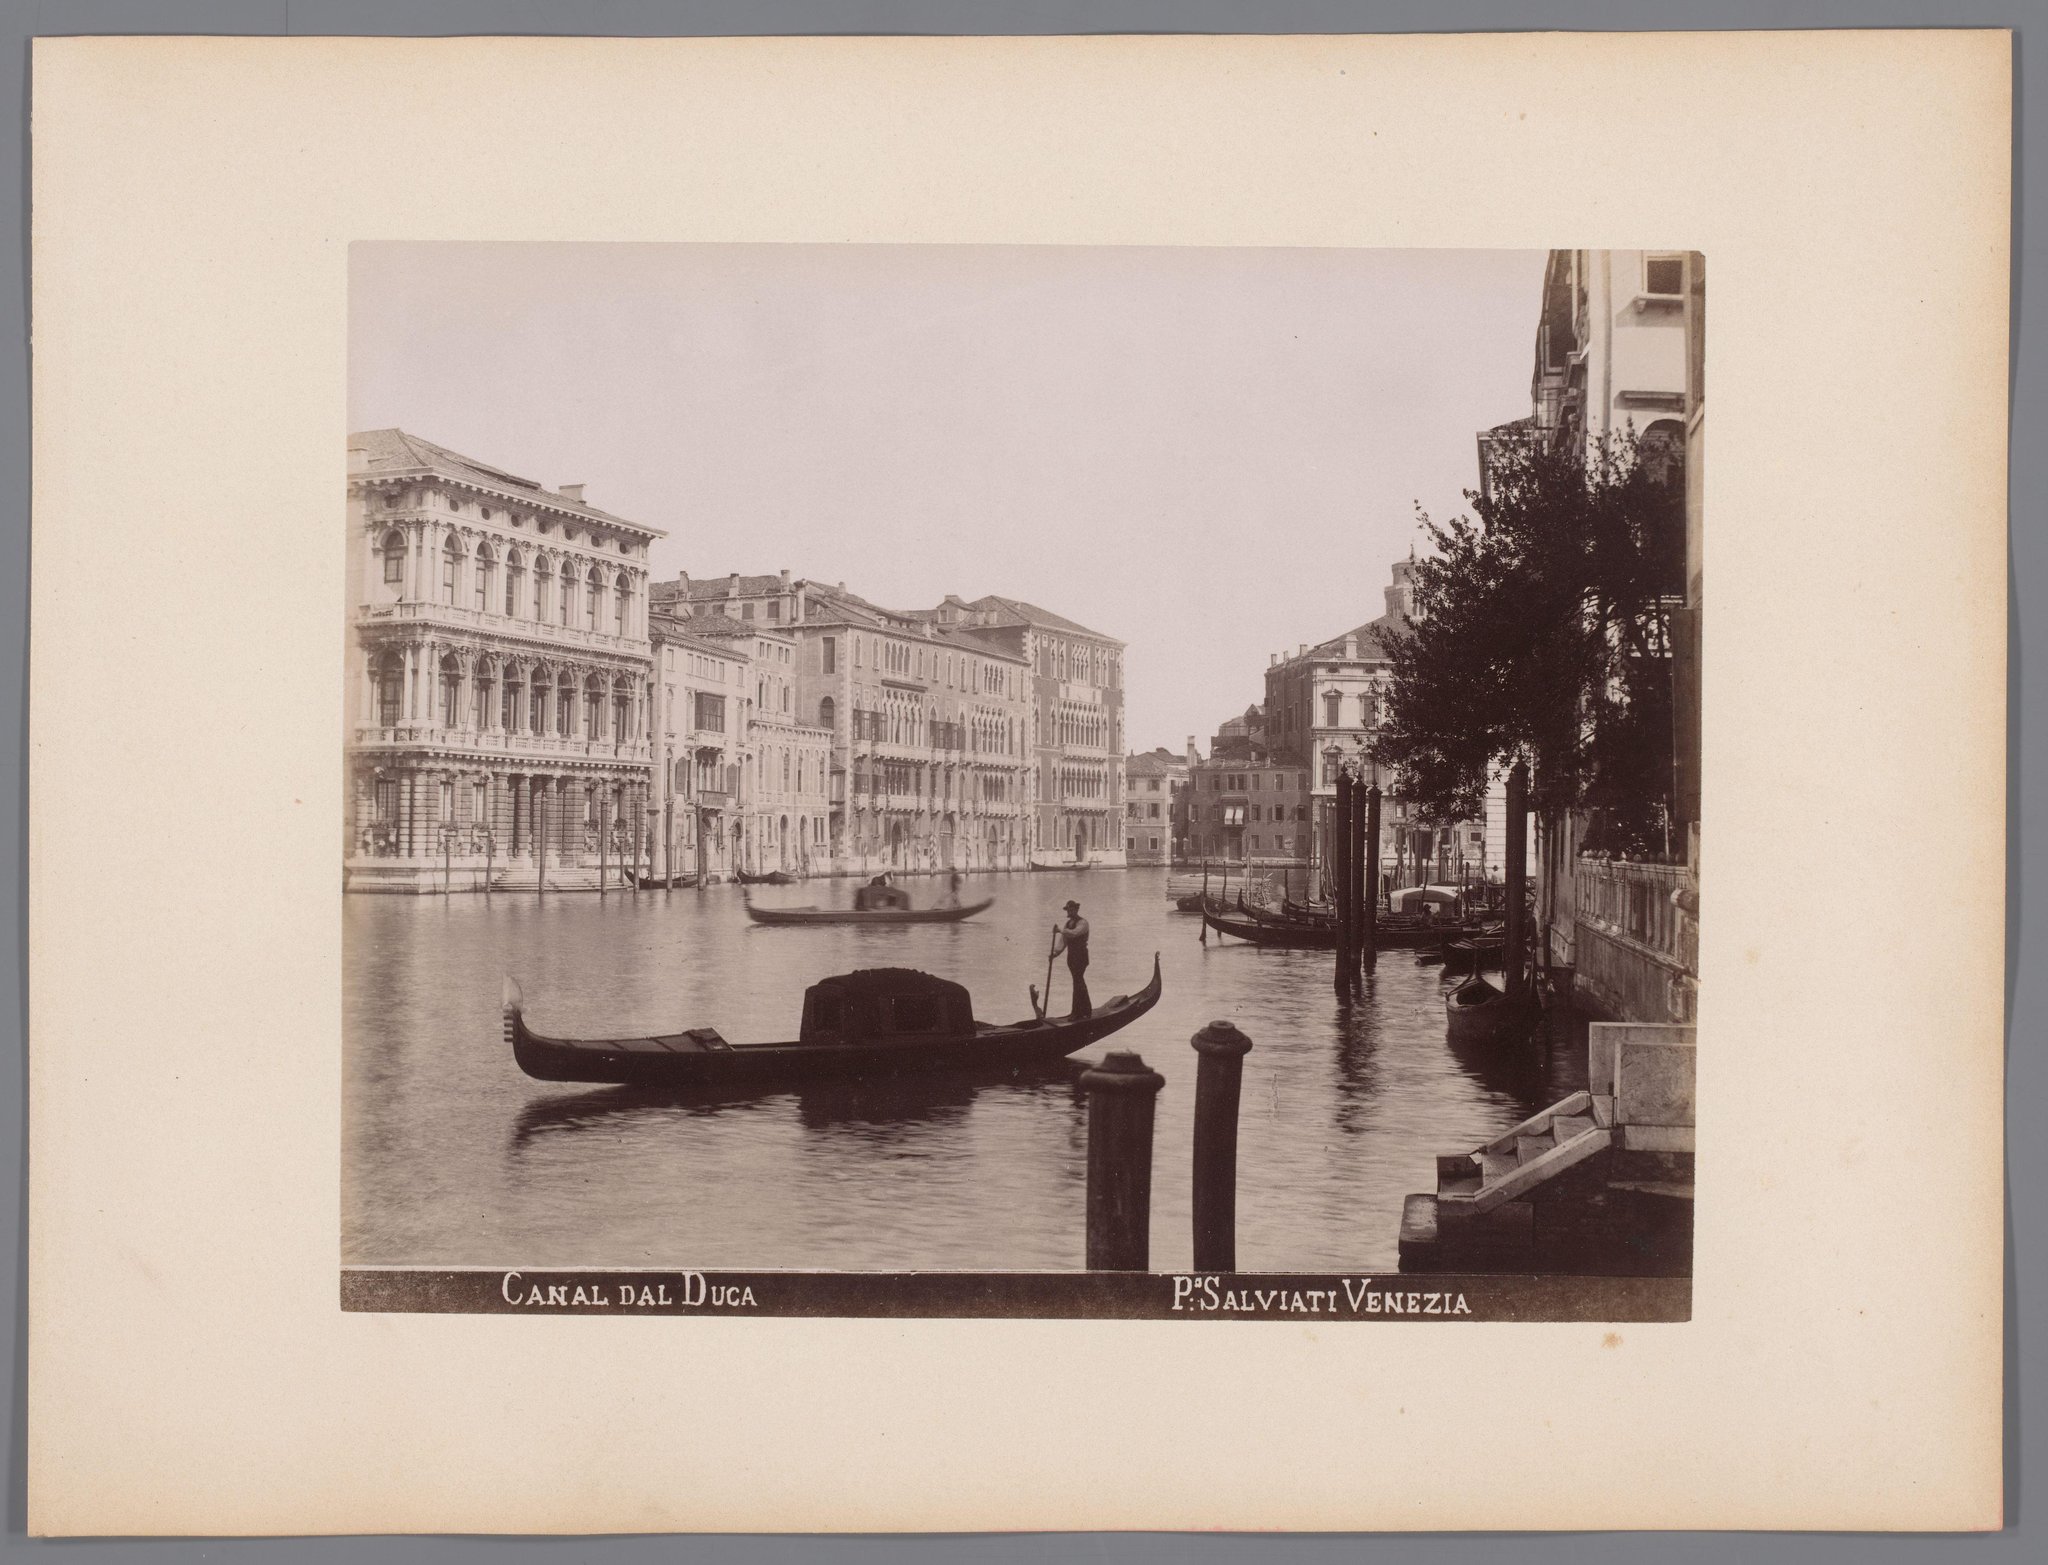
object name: photograph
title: Canal dal Duca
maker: paolo salviati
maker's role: fotograaf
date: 1860-1870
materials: cardboard, paper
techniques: albumen print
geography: venice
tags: canal, gondola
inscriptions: inscription: ‘Venetié’